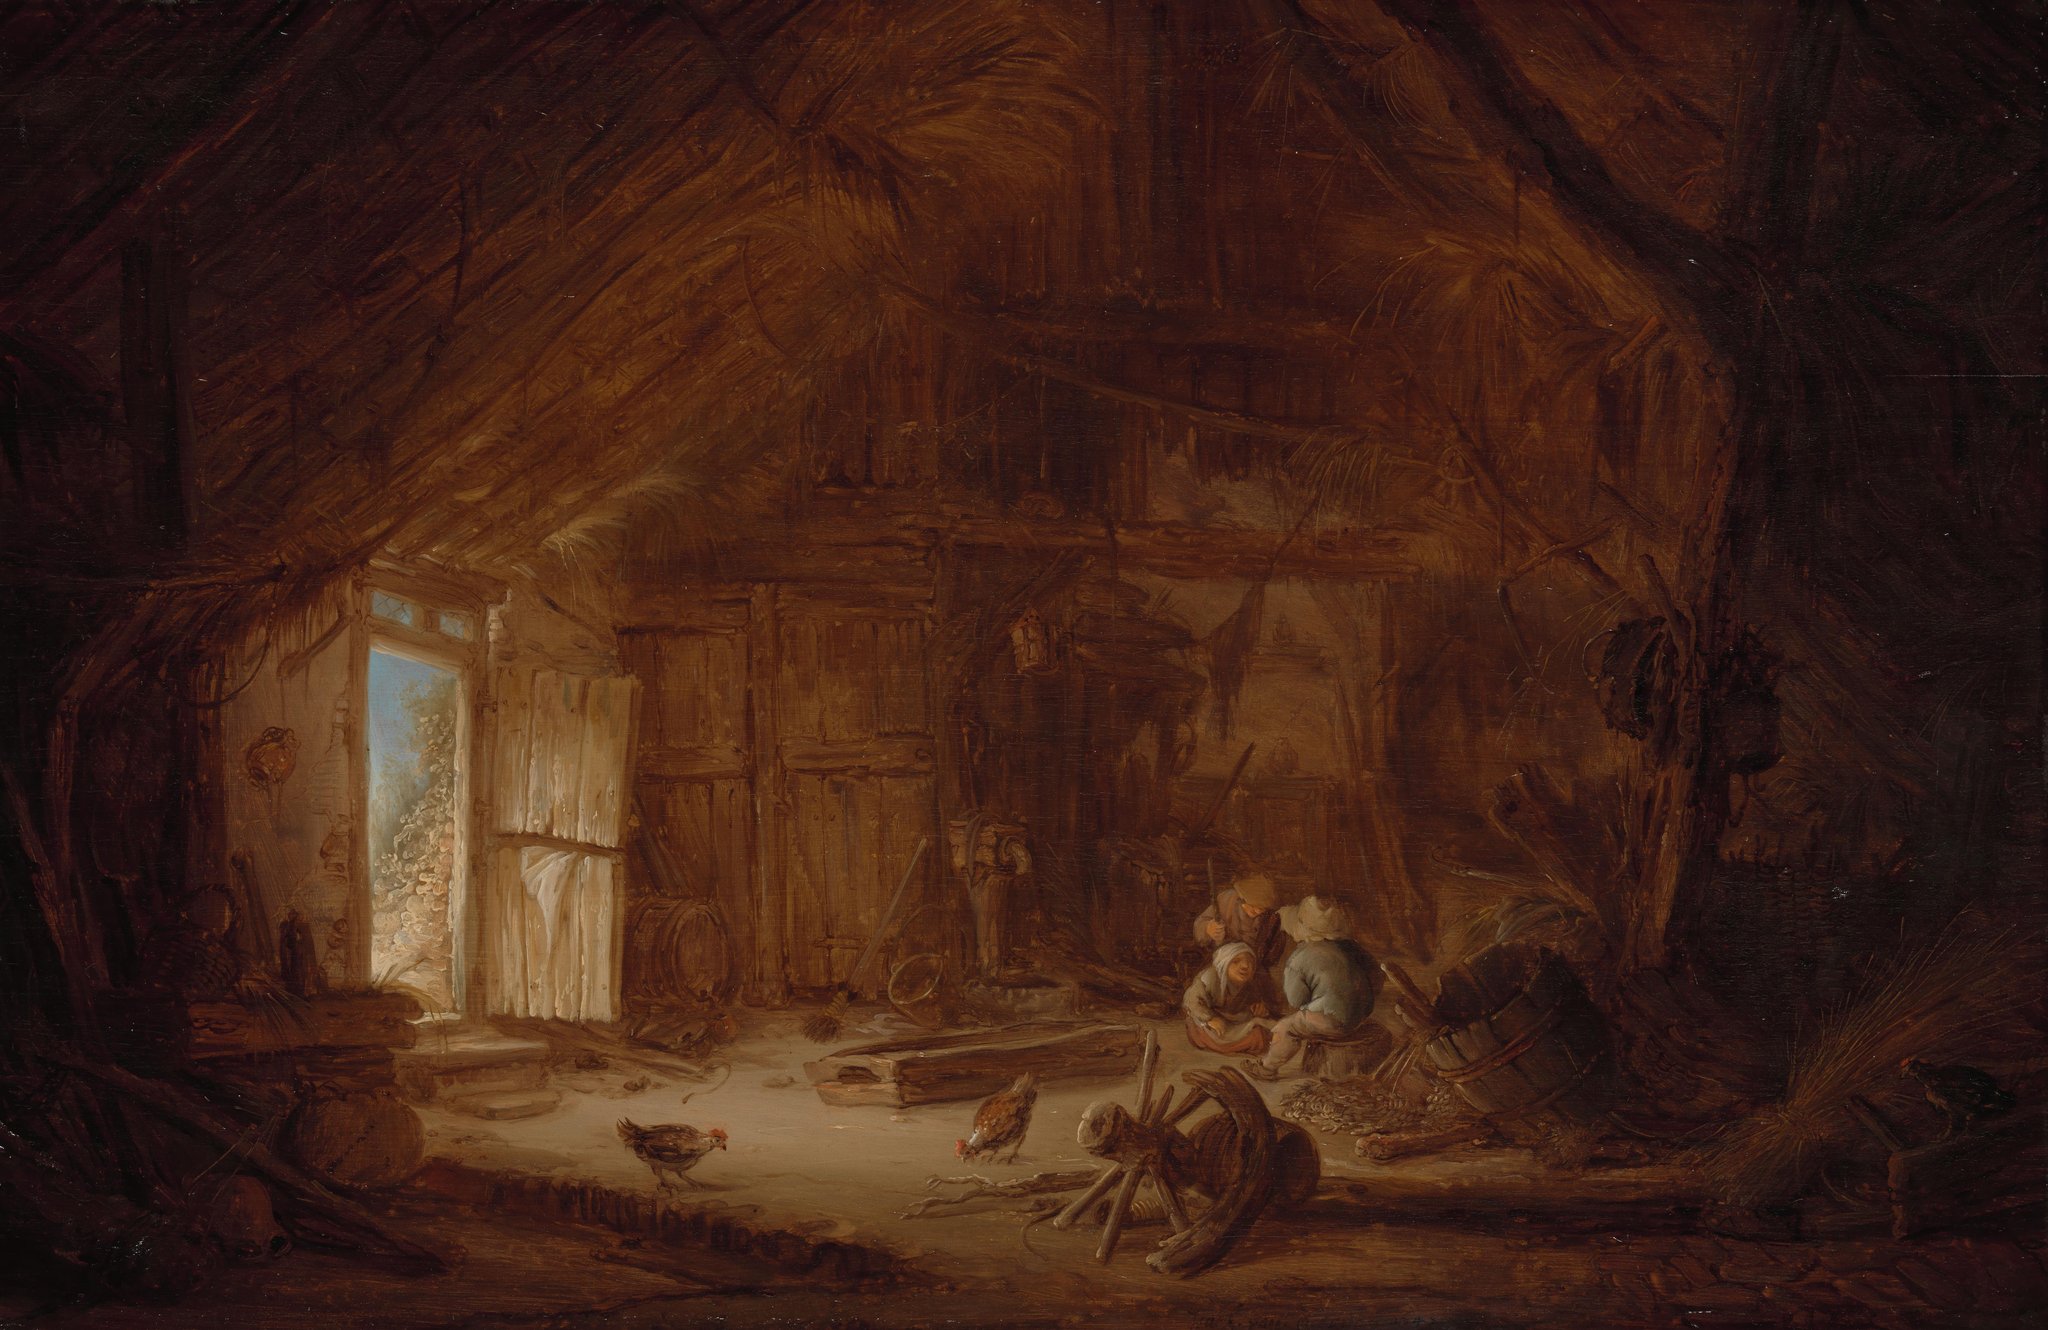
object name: painting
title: Interior of a Stable with three Children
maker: isaac van ostade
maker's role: draughtsman, painter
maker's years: 1621-1649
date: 1642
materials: oil, panel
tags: children's games and plays, barn - aa - civic architecture: inside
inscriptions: signature and date: ‘Isack v. Ostade 1642’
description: In een vervallen en rommelig stalinterieur spelen drie kinderen. Links in het beeld is een openstaande deur te zien waardoor een helder licht het verder donkere interieur binnenvalt. Op de voorgrond een gebroken karrenwiel en enkele kippen.